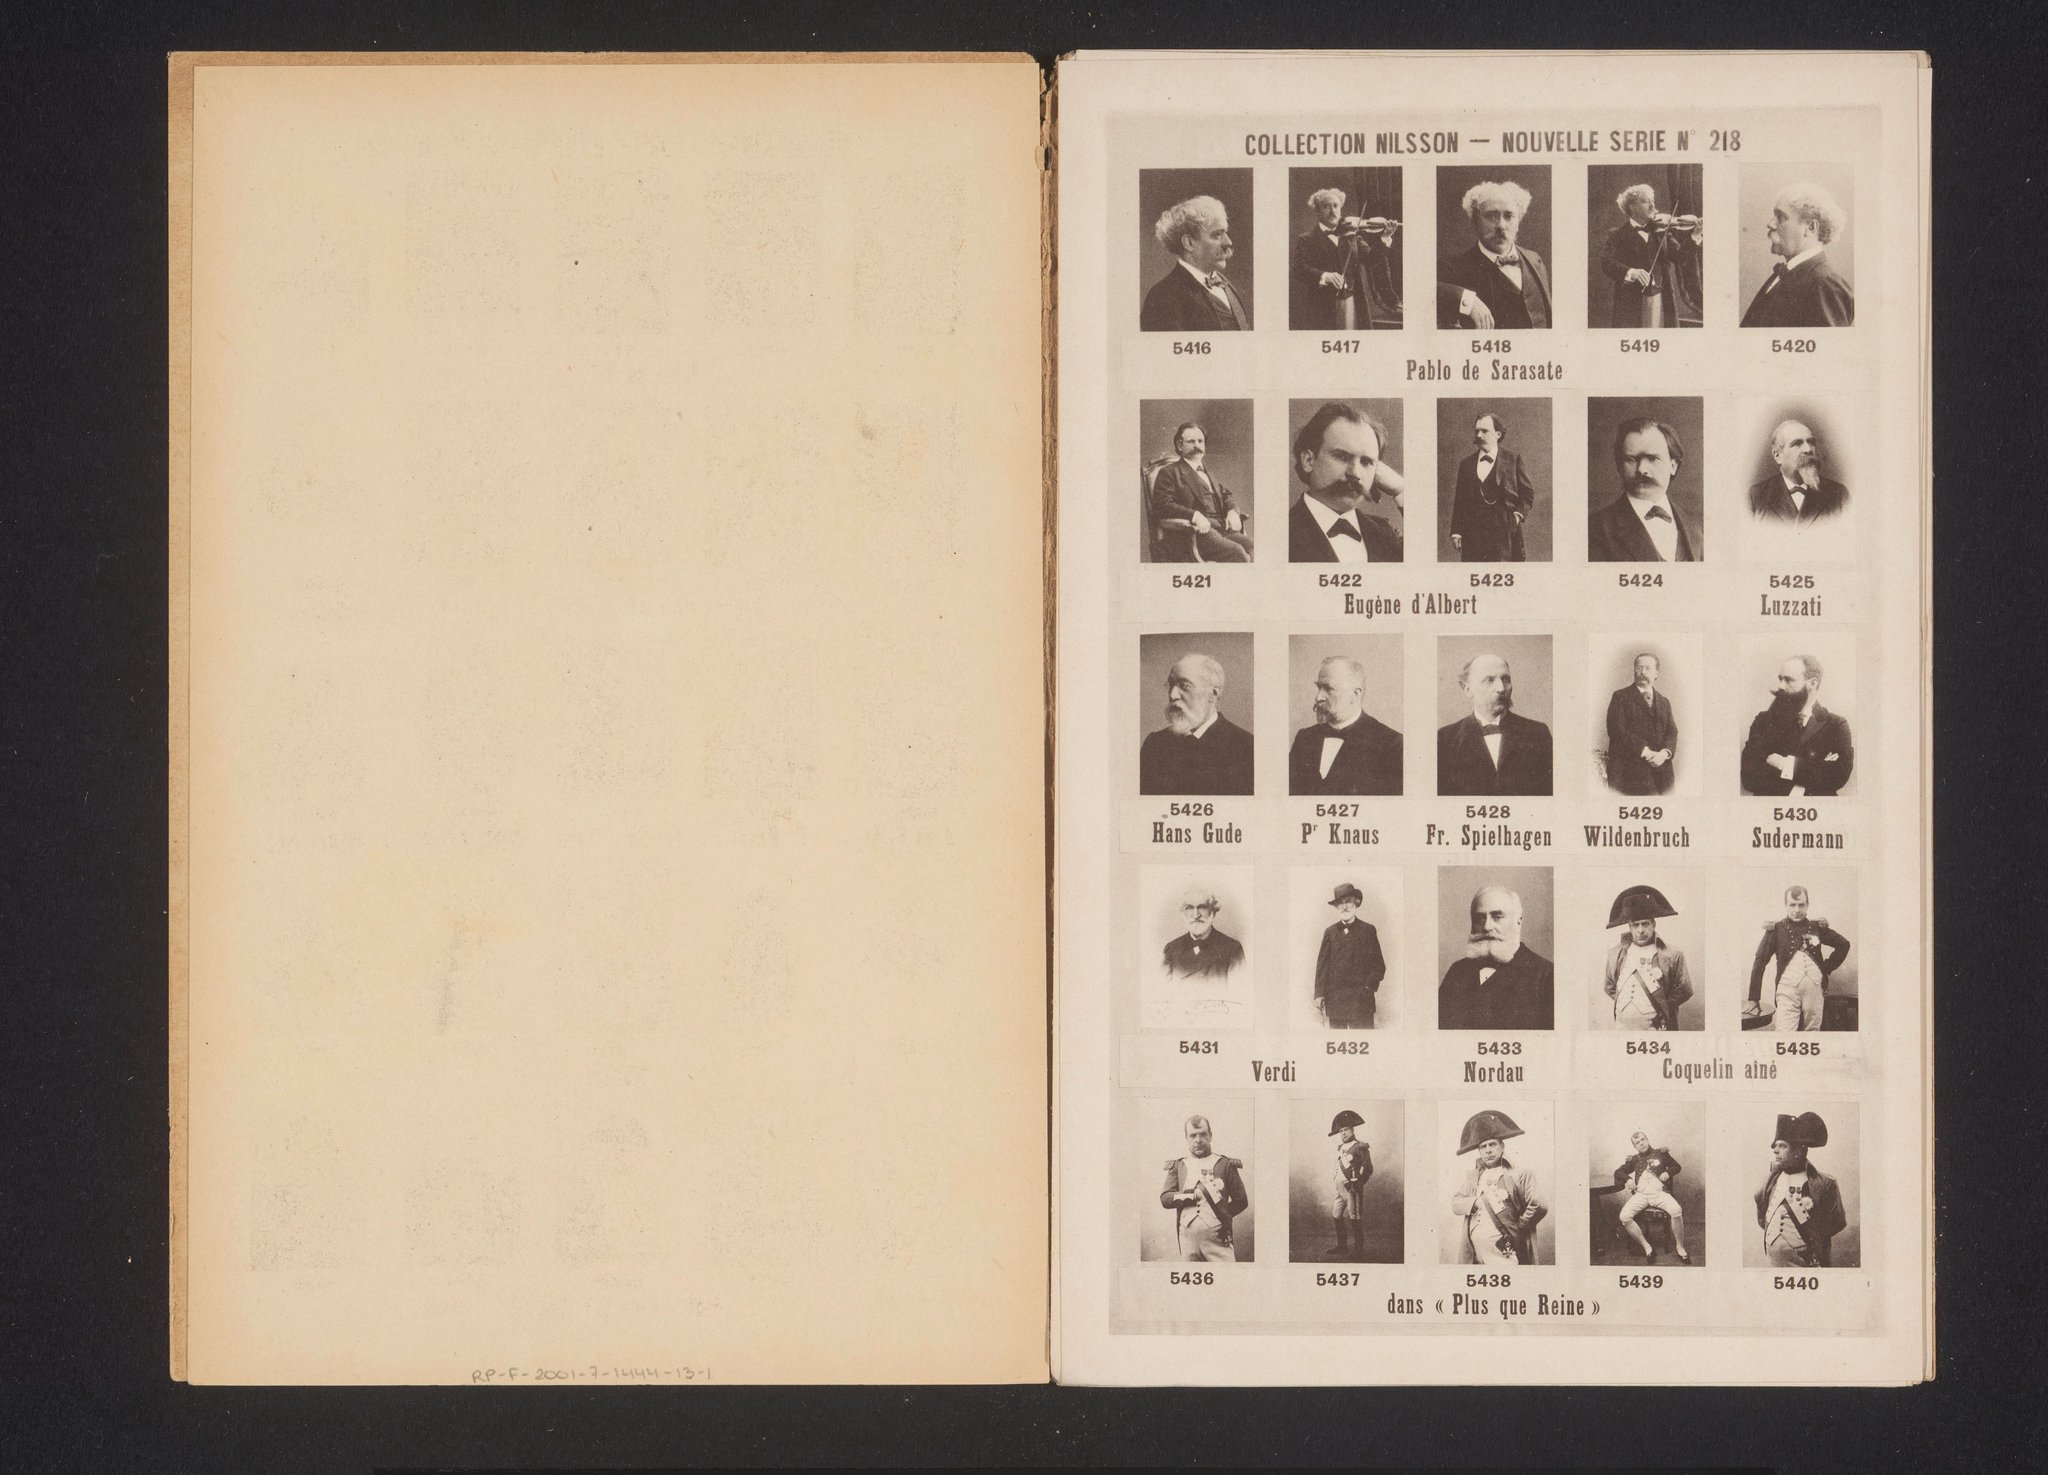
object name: page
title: Collection Nilsson - Nouvelle Série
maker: Anonymous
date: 1894-1899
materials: paper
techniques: photograph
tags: glasgow, historical persons, portrait of a musician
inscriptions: number: ‘No 218’, inscription: ‘Pablo de Sarasate/ Eugène d'Albert Luzzati/ Hans Gude Pr Knaus Fr. Spielhagen Wildenbruch Sudermann/ Verdi Nordau Coquelin ainé/ dans <<Plus que Reine>>’